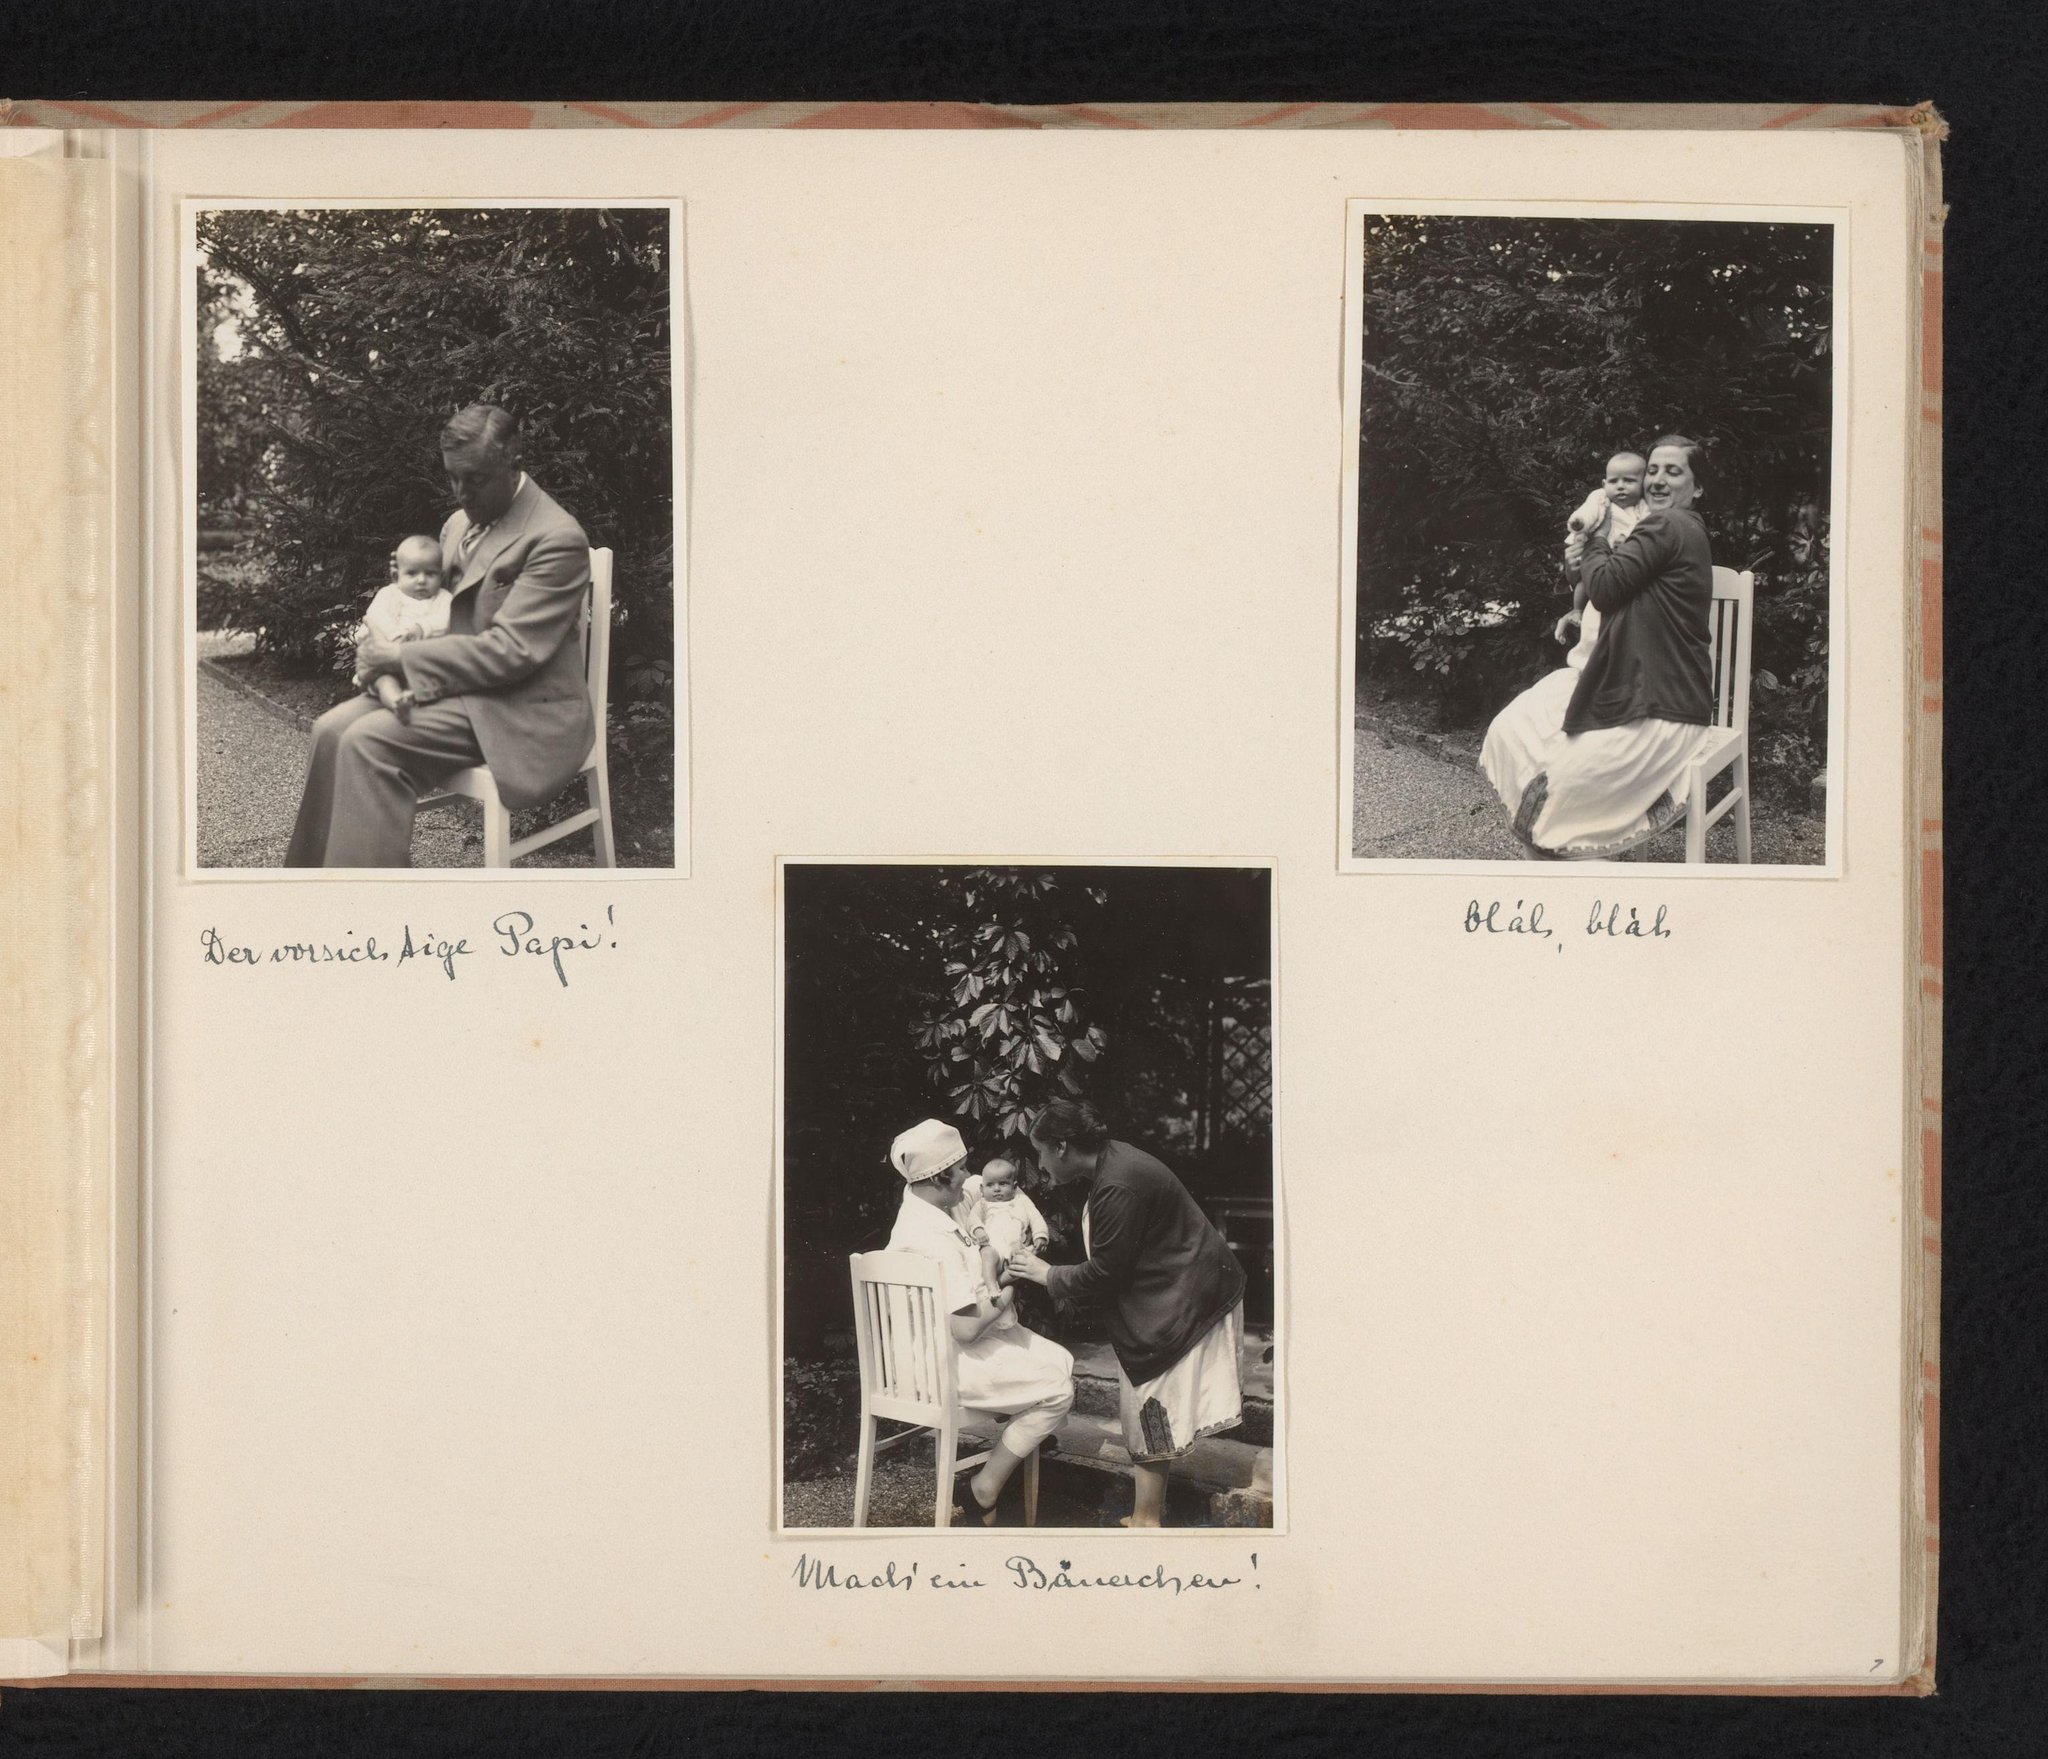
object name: photograph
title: Isabel Wachenheimer drie maanden oud met haar moeder Else Wachenheimer-Moos, haar vader Eugen Wachenheimer en een onbekende verpleegster, september 1928, Stuttgart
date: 1909-1928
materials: paper, photographic support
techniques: gelatin silver print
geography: stuttgart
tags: eugen wachenheimer, else wachenheimer-moos, leiden, isabel wachenheimer-elon, family life at home, mother and baby or young child, infant, baby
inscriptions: inscription: ‘Der vorsichtige Papi!//Mach ein Bäuerchen!//Bláh, bláh’